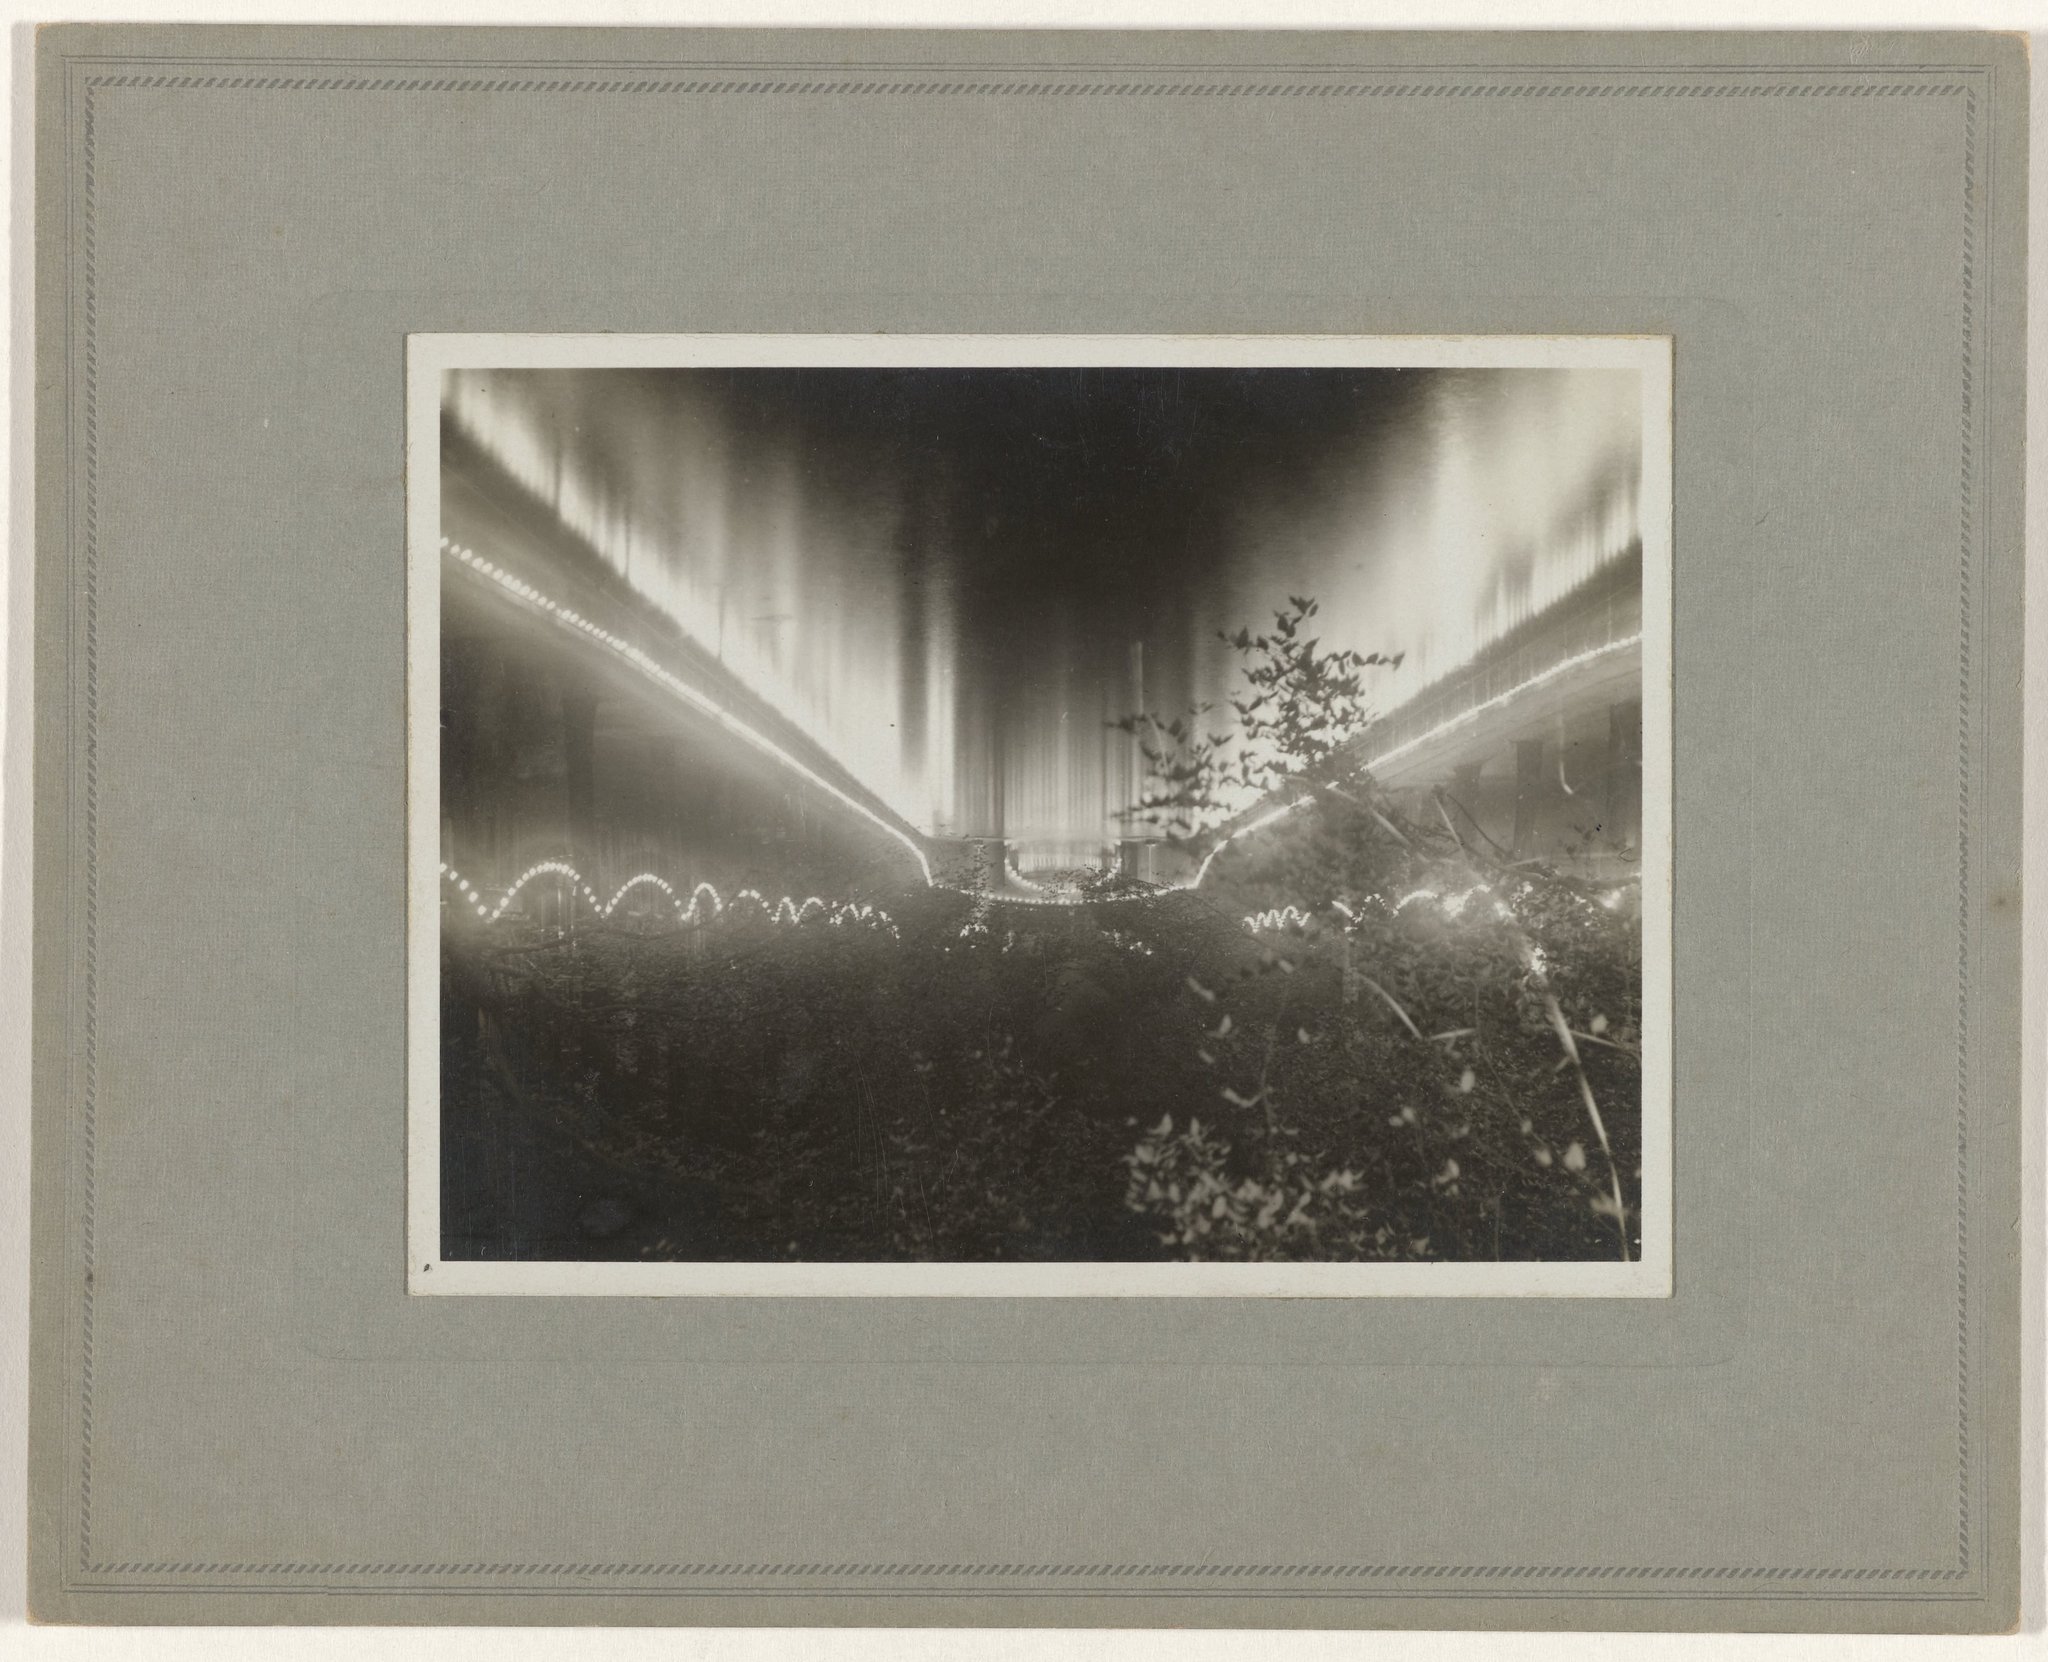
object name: photograph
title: Verlichte gracht te Amsterdam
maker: Anonymous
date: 1923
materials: cardboard, photographic support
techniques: gelatin silver print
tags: the hague, print maker, wilhelmina of the netherlands, public festivities at other royal events, not meant or mentioned above (+ illumination, fire-works ~ festive activities), canal, amsterdam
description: Illuminatie op de gracht te Amsterdam bij 25-jarig regeringsjubileum van koniging Wilhelmina, 1923.